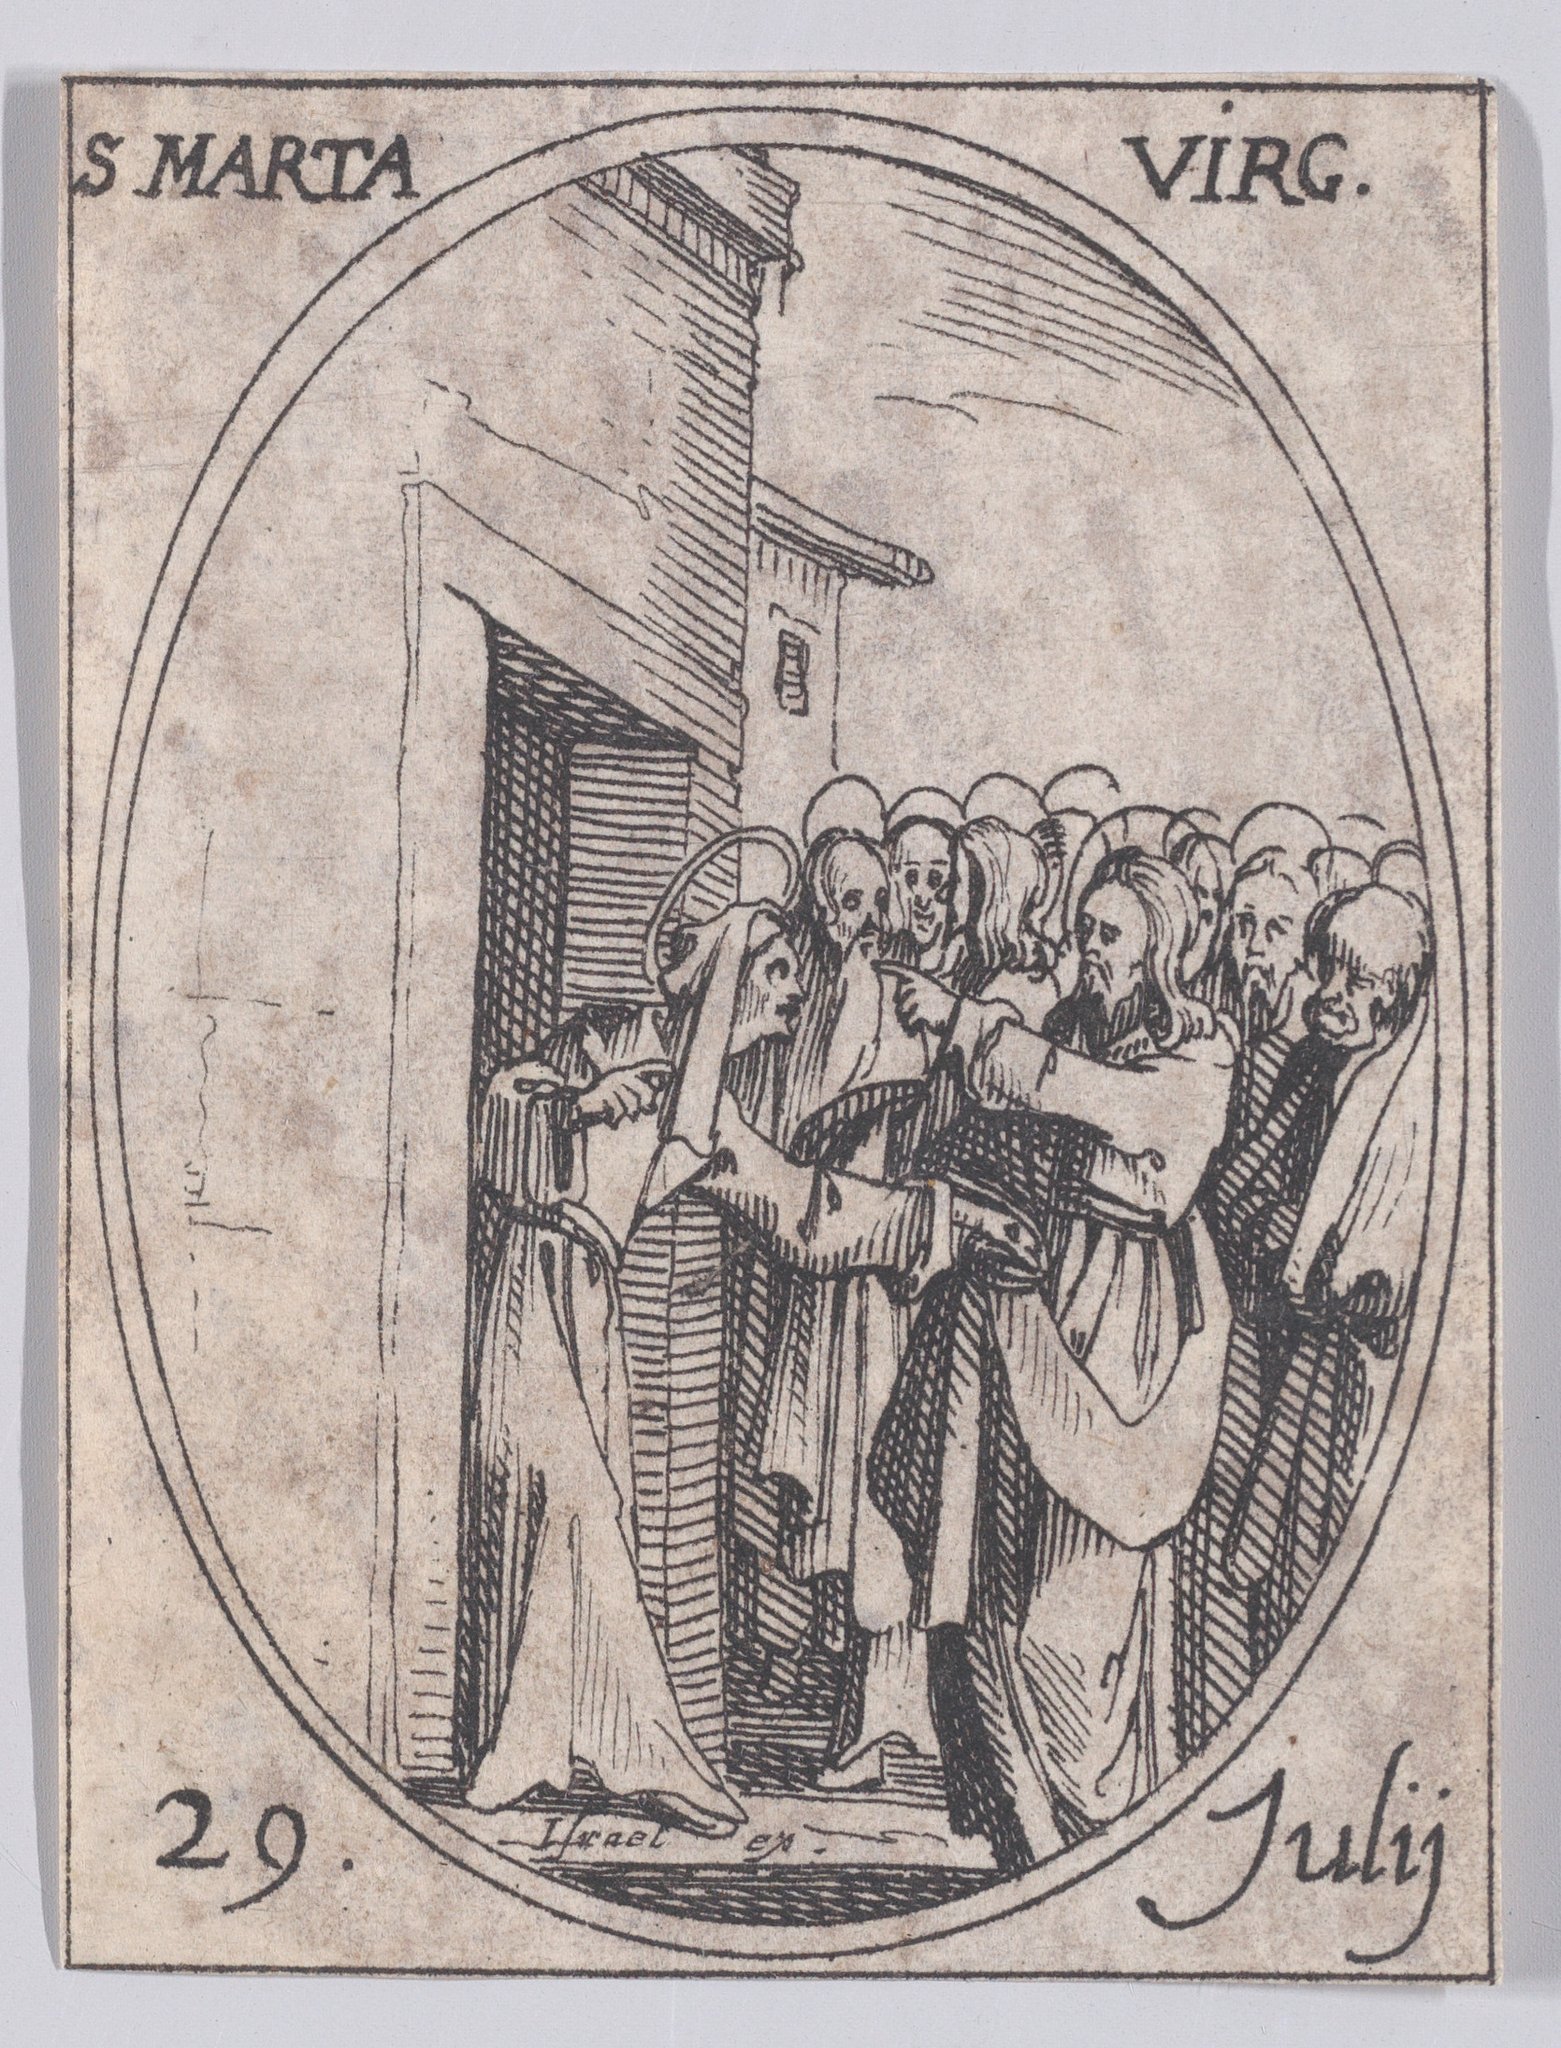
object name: print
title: Ste. Marthe, vierge (St. Martha, Virgin), July 29th, from "Les Images De Tous Les Saincts et Saintes de L'Année" (Images of All of the Saints and Religious Events of the Year)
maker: jacques callot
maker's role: artist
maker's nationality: french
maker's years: 1592-1635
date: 1636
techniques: etching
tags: men,women,saints